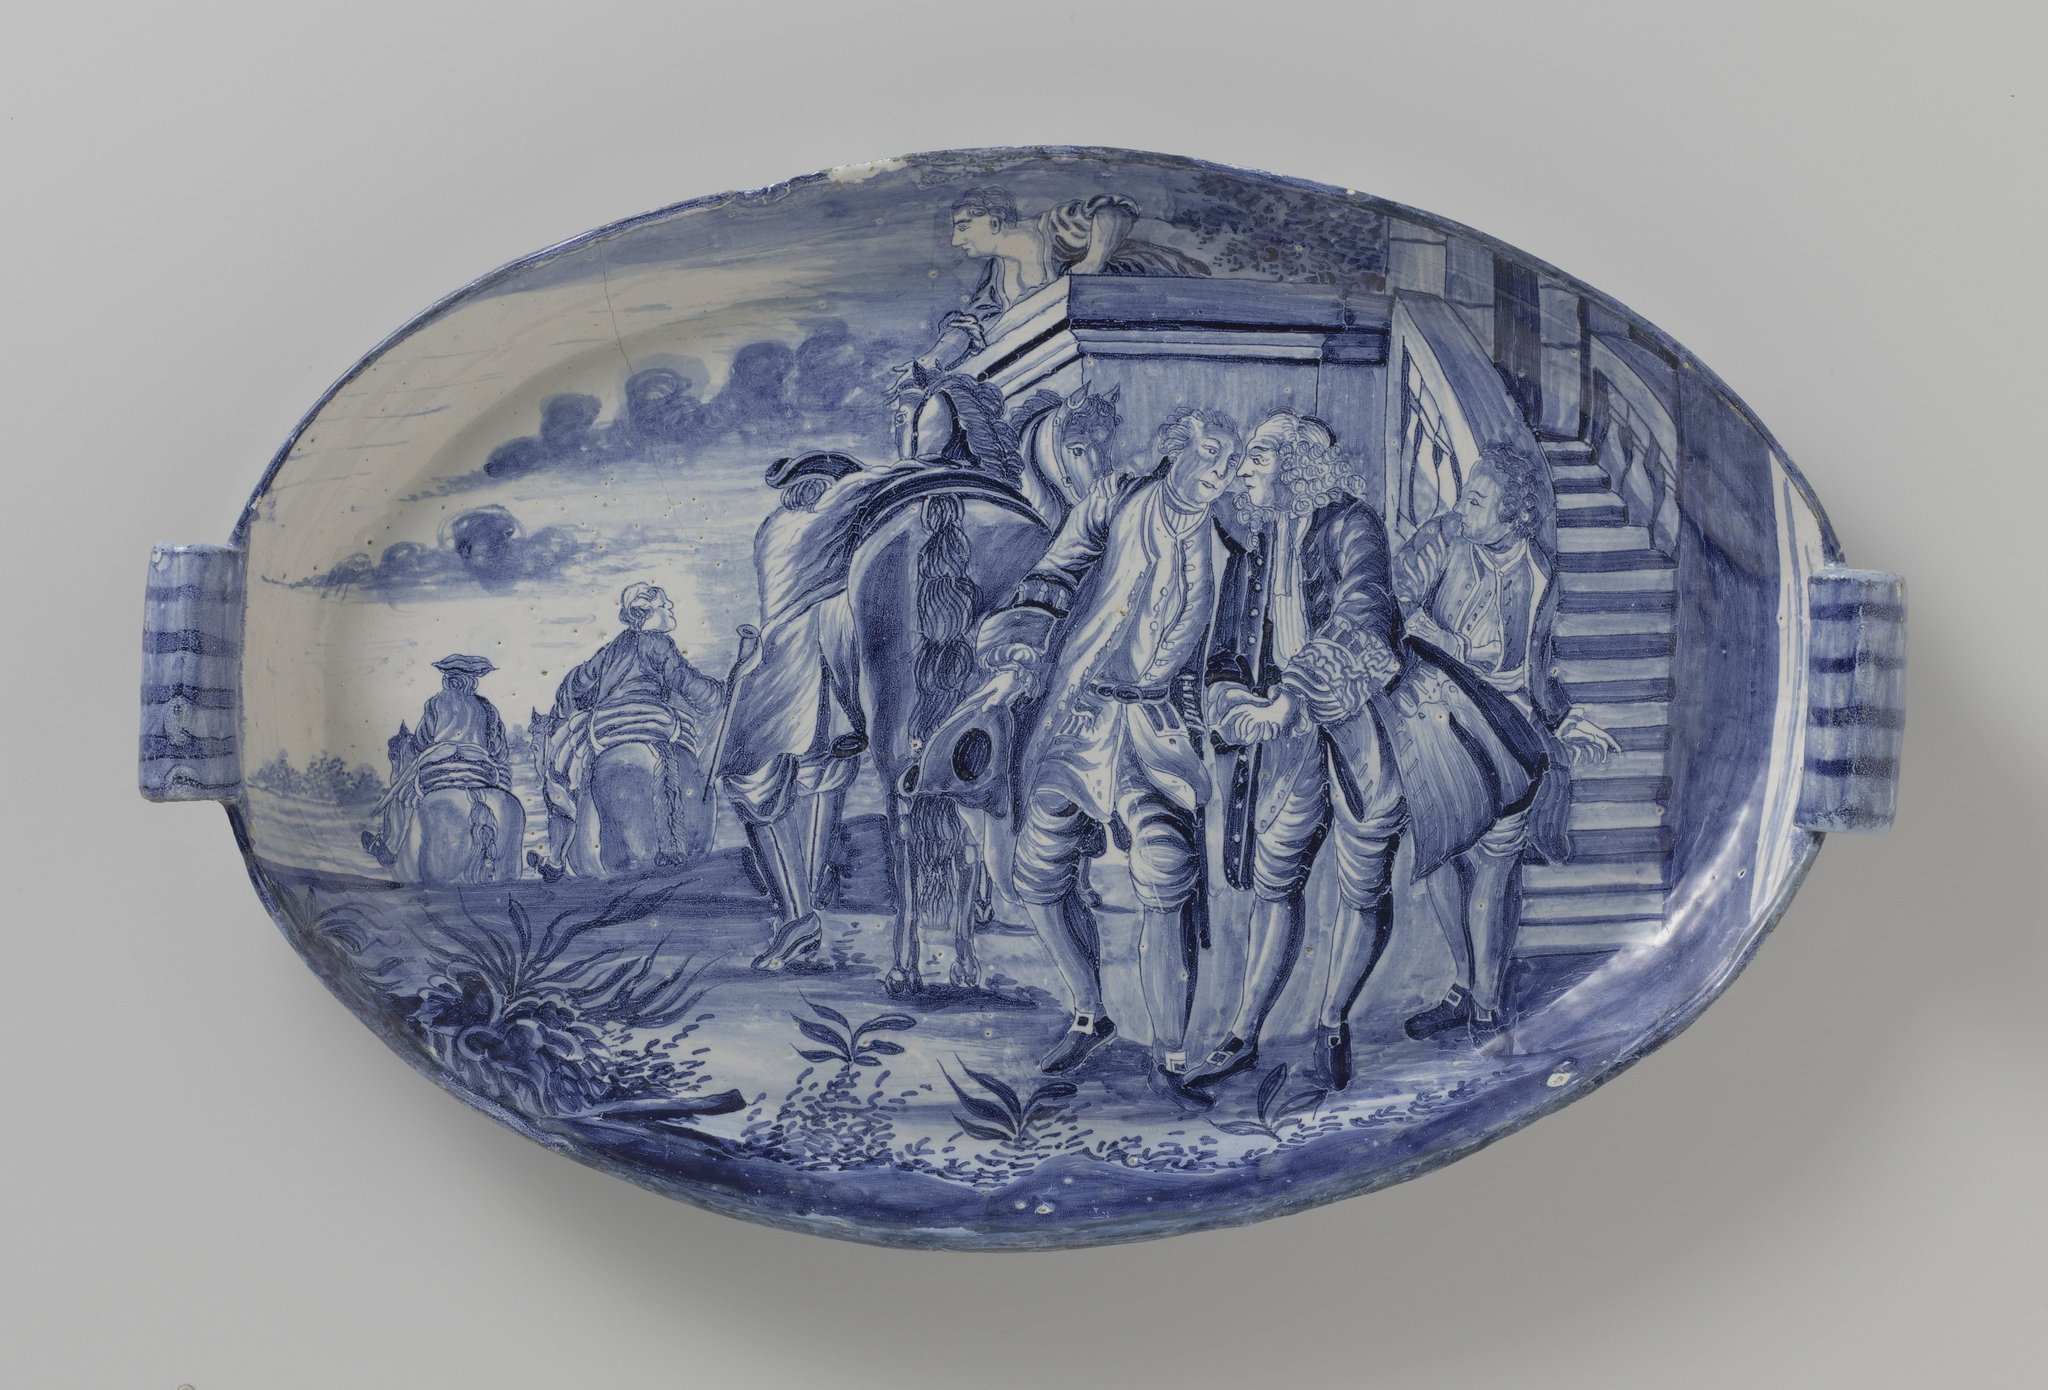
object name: dienblad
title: Serving tray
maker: Anonymous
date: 1780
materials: earthenware, glaze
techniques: painted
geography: amsterdam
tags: horse, taking leave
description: Ovaal dienblad van blauw beschilderde faience, met twee handgrepen. Op het blad is rechts een bordes met een trap geschilderd. Op het bordes staat een vrouw. Naast de trap staan drie mannen. Voor het bordes staat een man naast een paard en links rijden twee ruiters op de rug gezien.